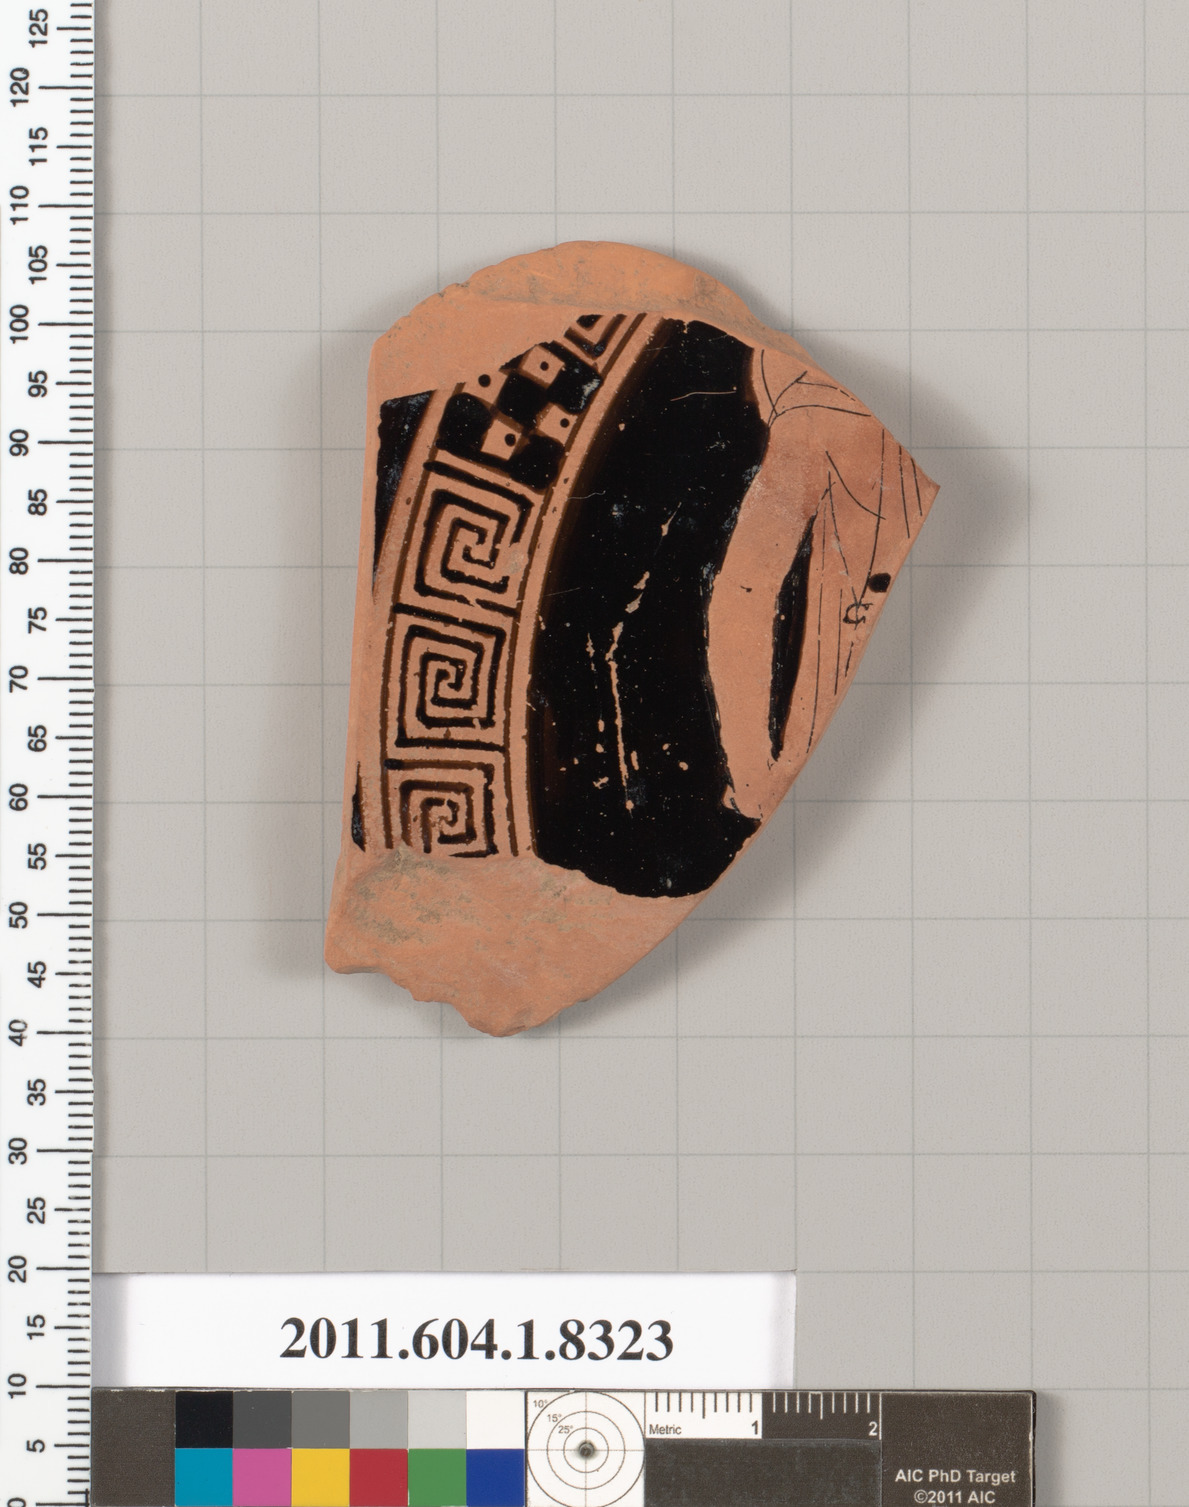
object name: kylix fragment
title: Terracotta fragment of a kylix (drinking cup)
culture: greek, attic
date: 425-401 BCE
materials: terracotta